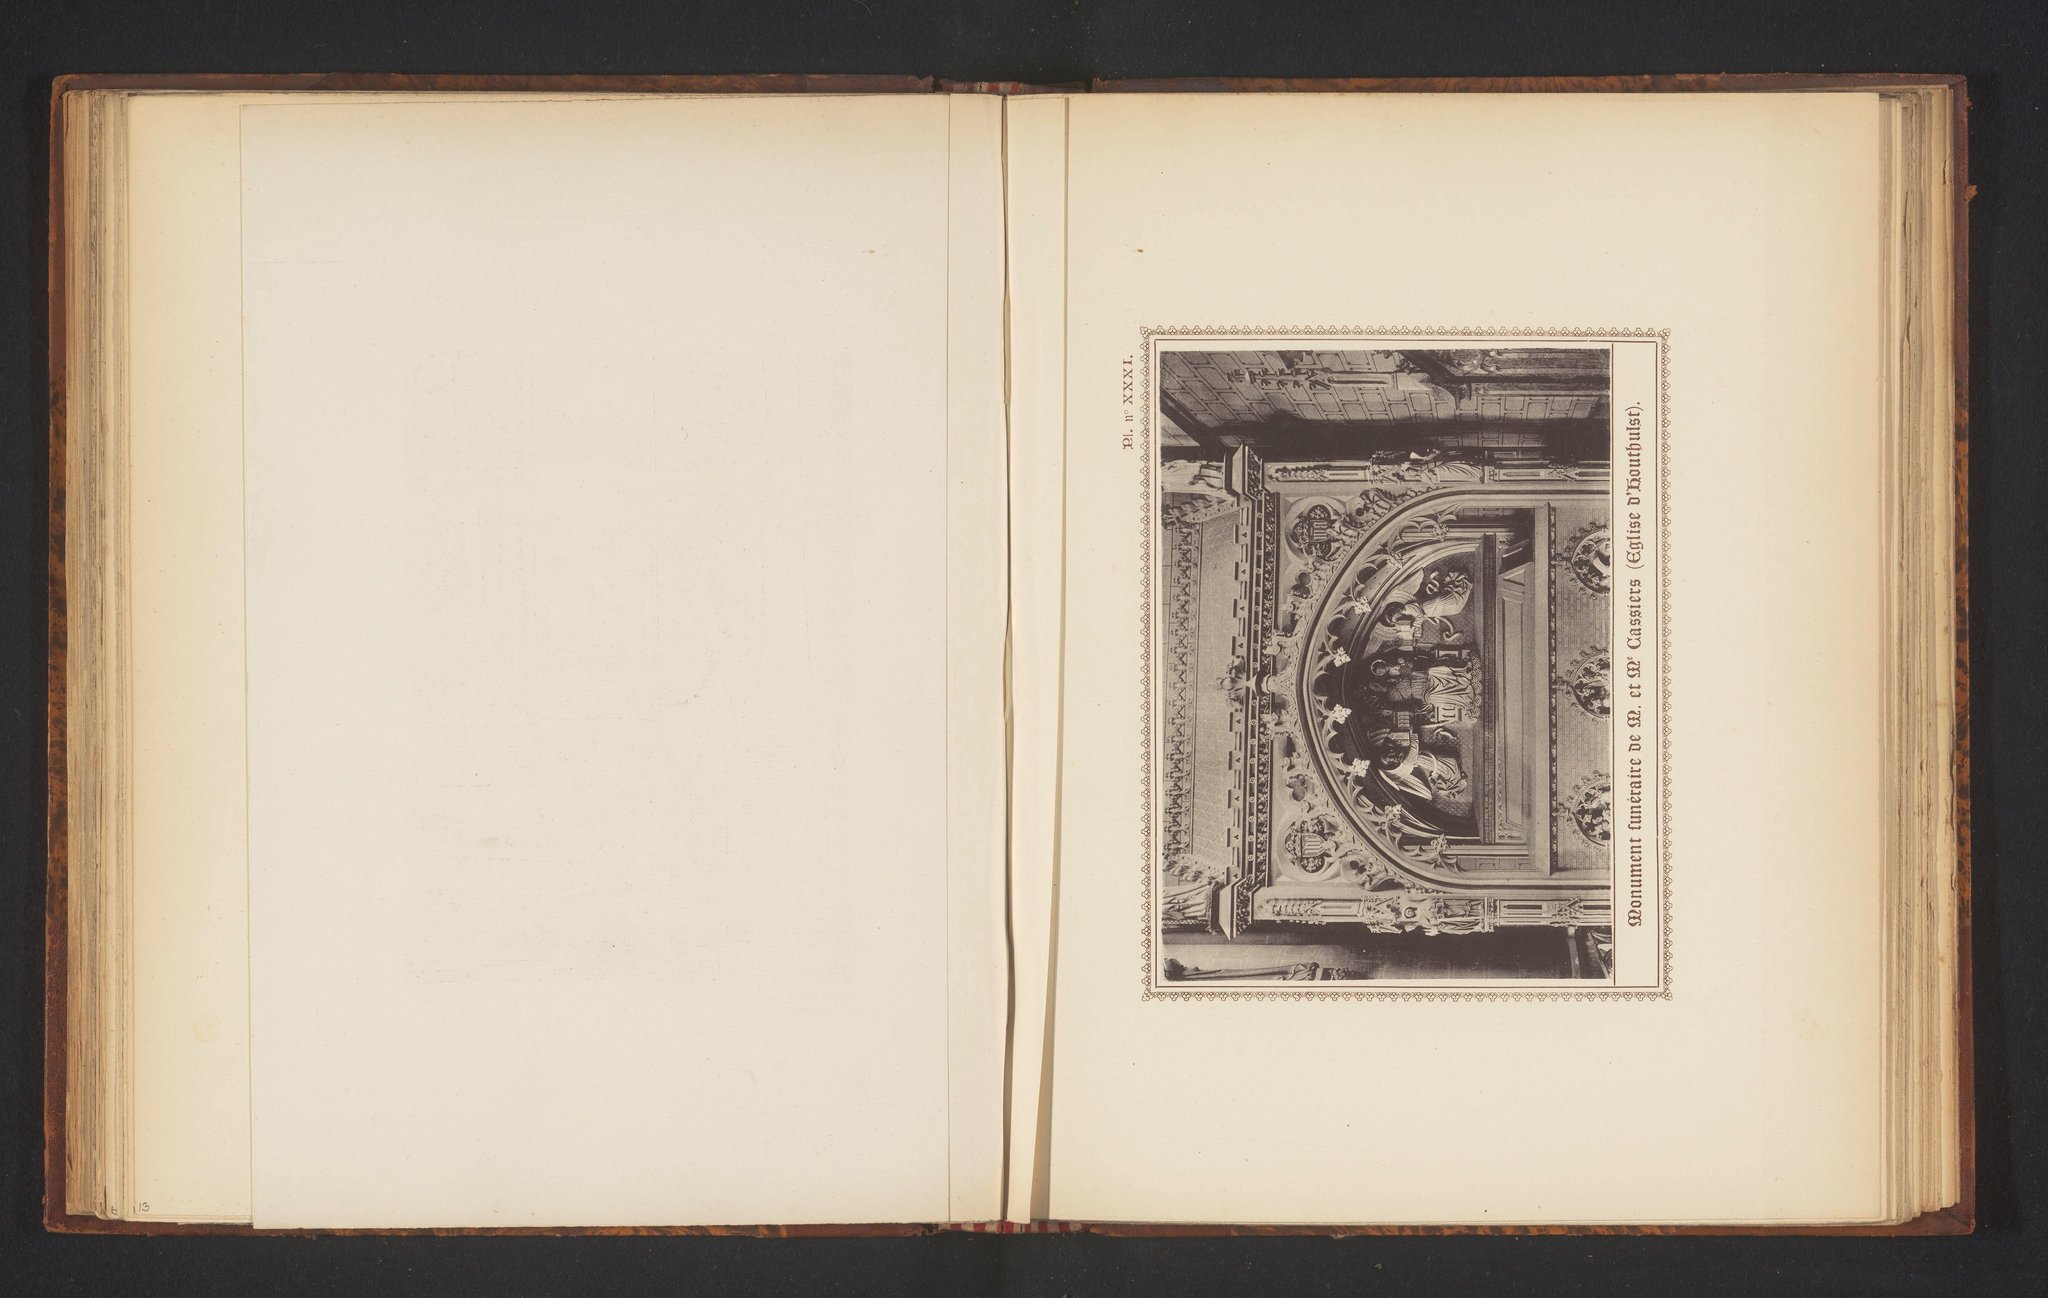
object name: photomechanical print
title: Grafmonument van het echtpaar Cassiers in de kerk van Houthulst, België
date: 1891-1896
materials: paper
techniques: photograph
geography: houthulst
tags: niche-tomb, wall-tomb, interior of church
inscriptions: number: ‘Pl. no XXXI.’